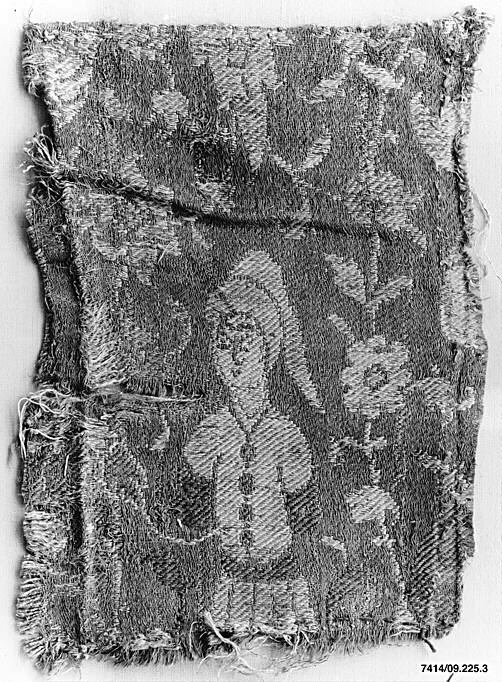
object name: textile fragment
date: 1501-1600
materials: metal thread, silk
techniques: lampas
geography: iran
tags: human figures,flowers